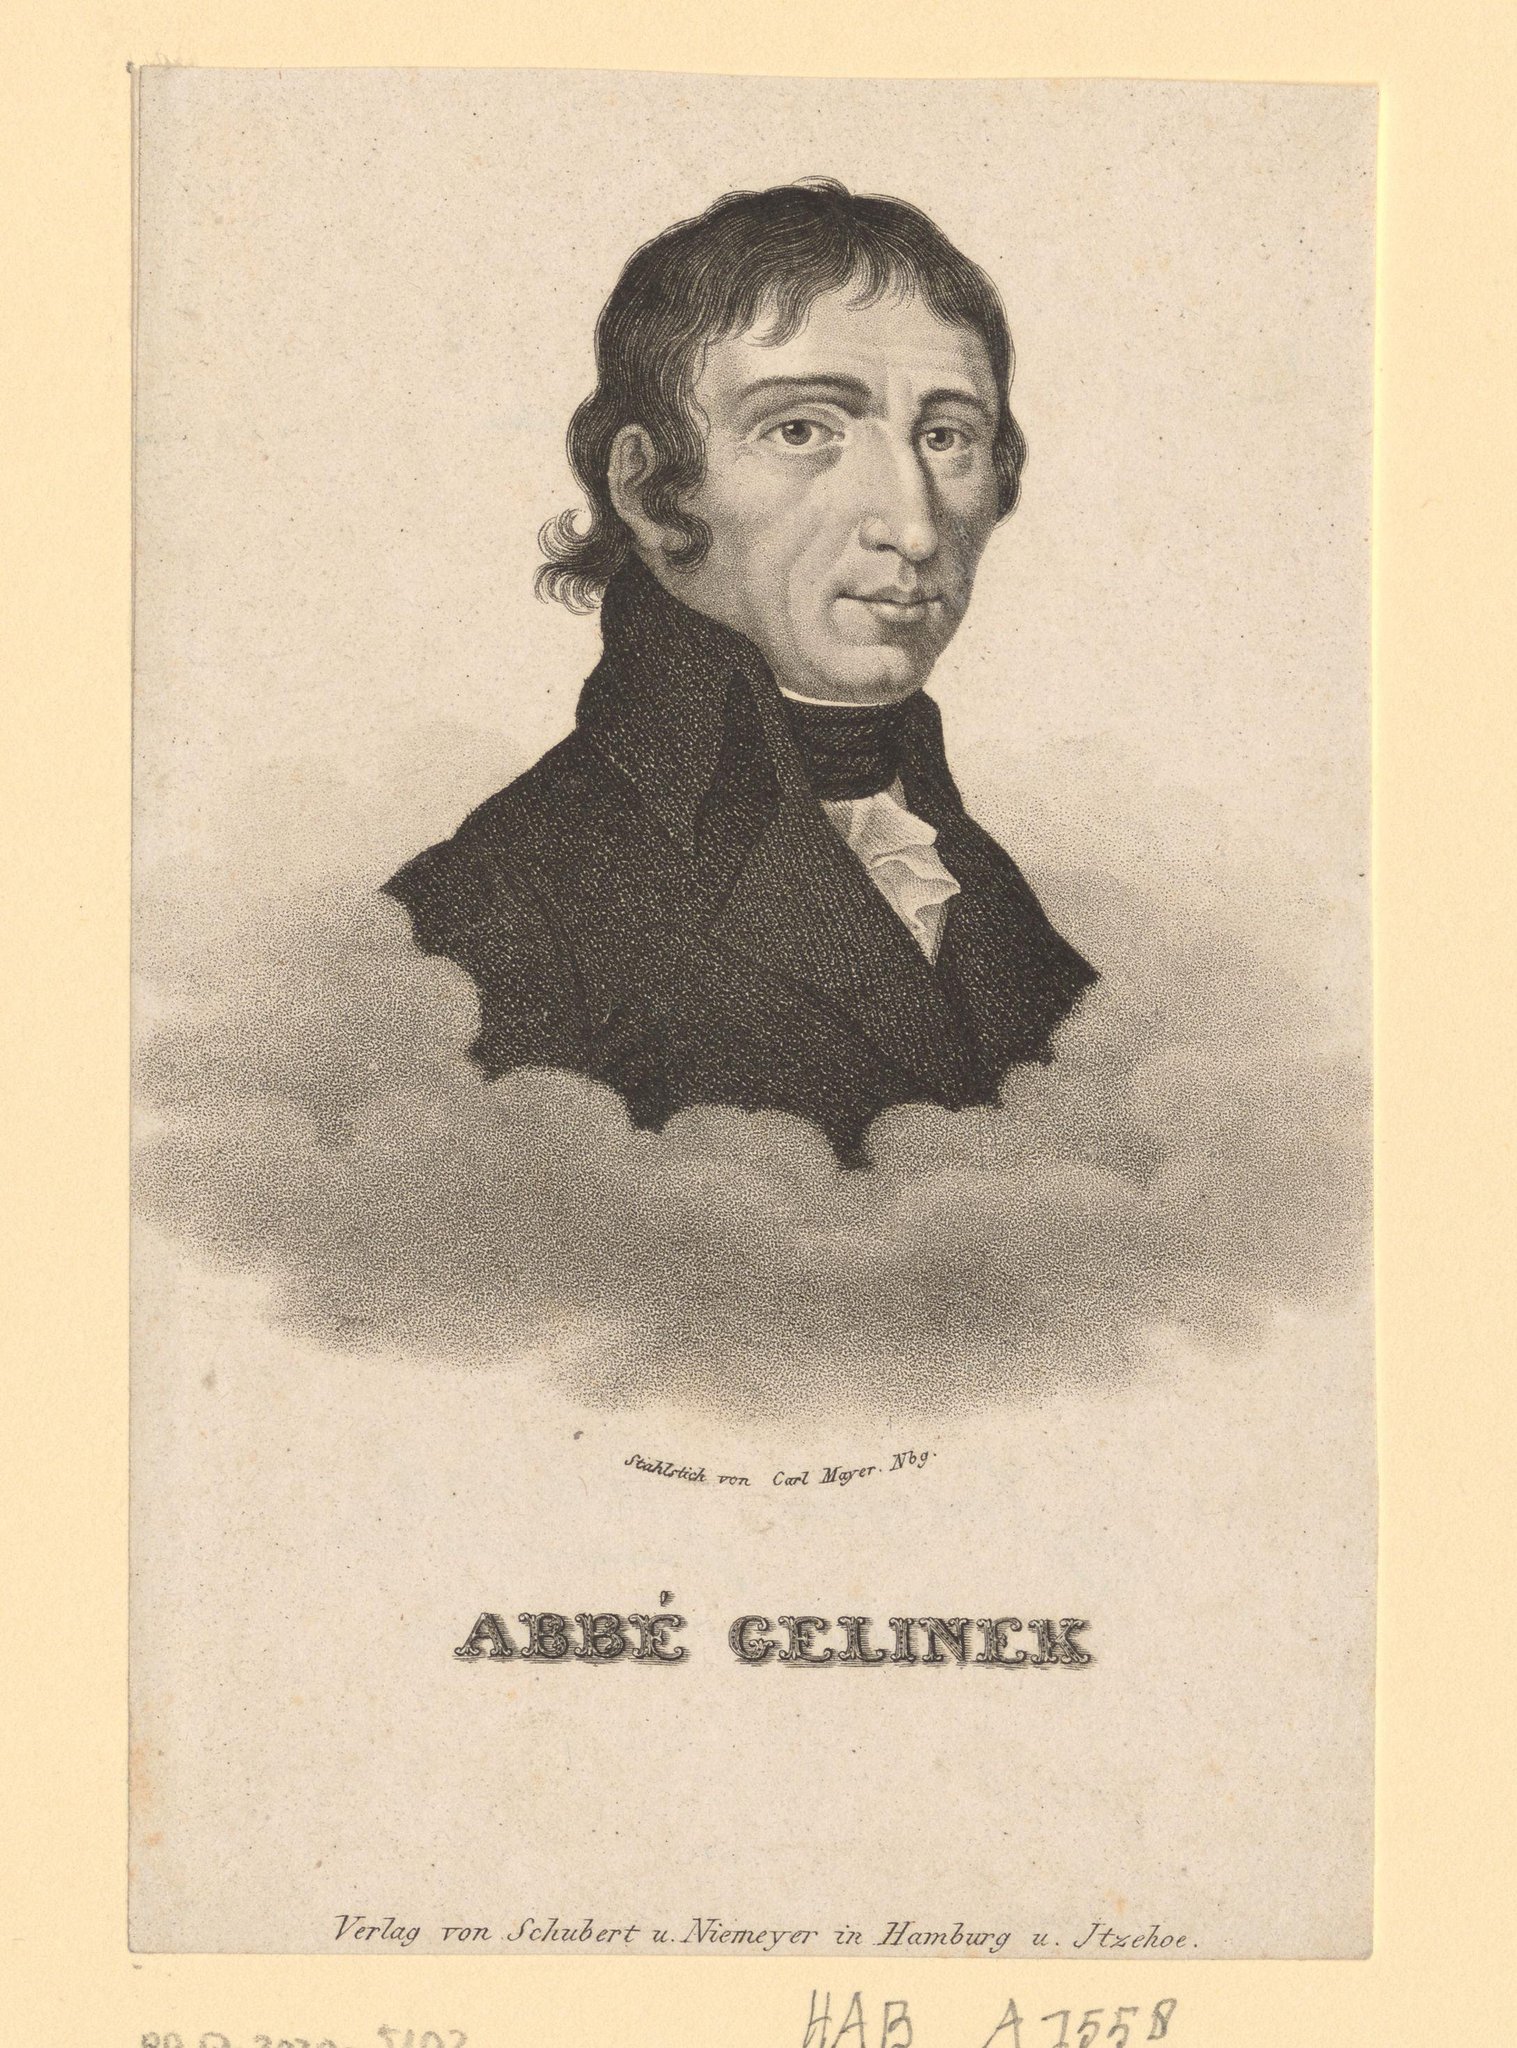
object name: print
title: Portret van Joseph Gelínek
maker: carl mayer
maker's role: print maker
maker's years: 1798-1868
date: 1829-1839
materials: paper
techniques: engraving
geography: hamburg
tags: vienna, historical persons, portrait of composer